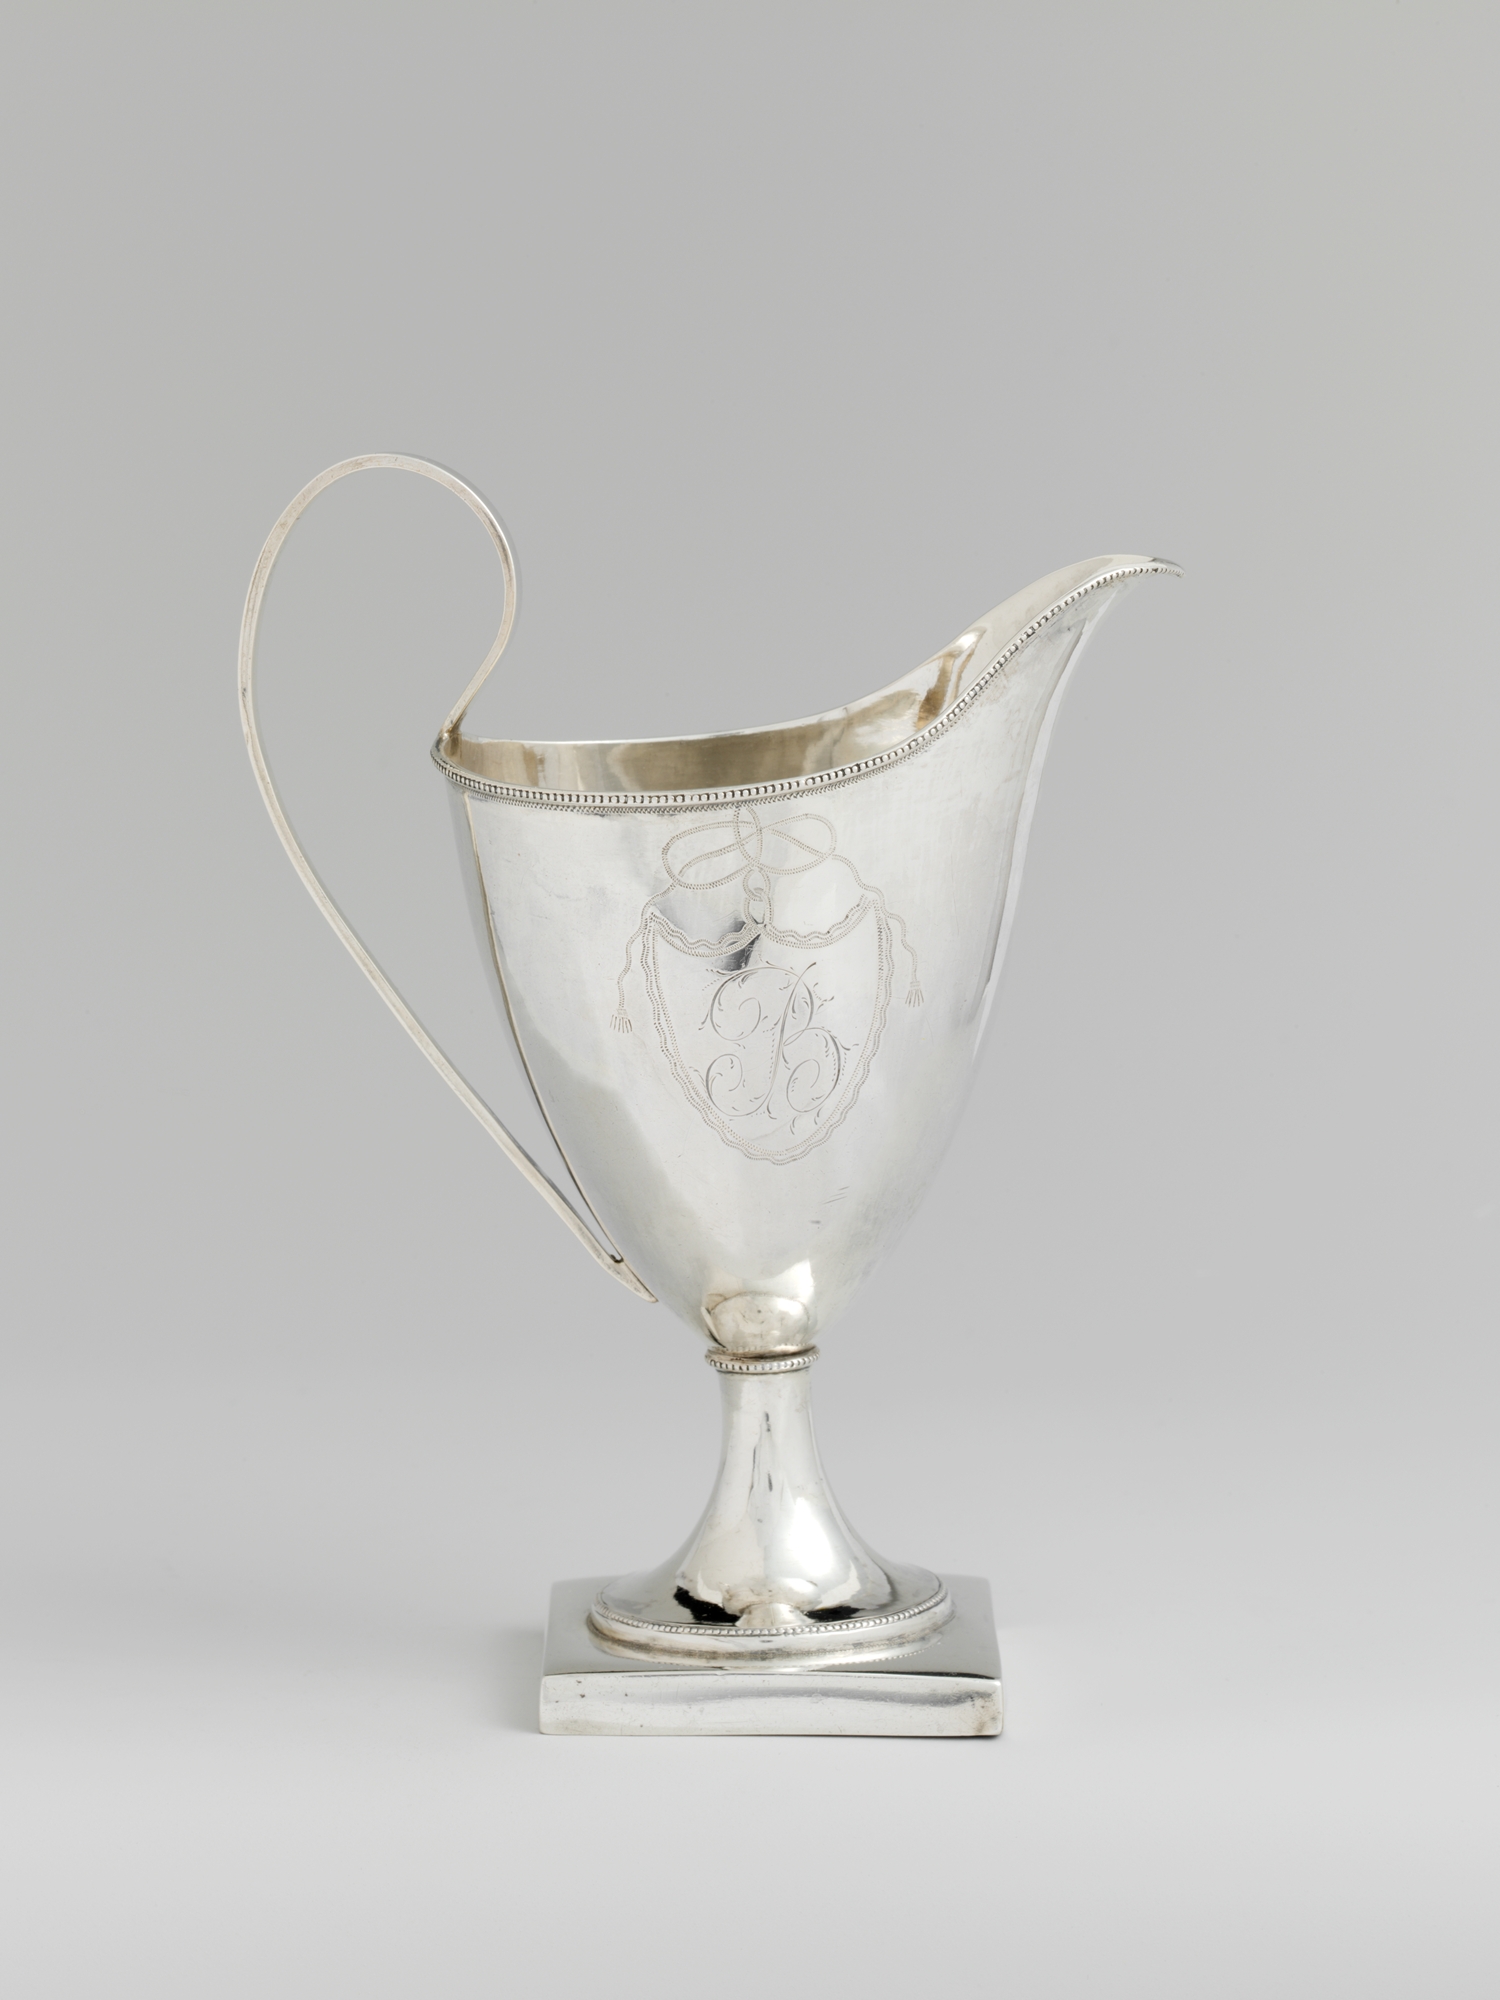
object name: cream pot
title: Creamer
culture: american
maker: james adam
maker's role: maker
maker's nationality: american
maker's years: 1755-1798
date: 1795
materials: silver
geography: united states